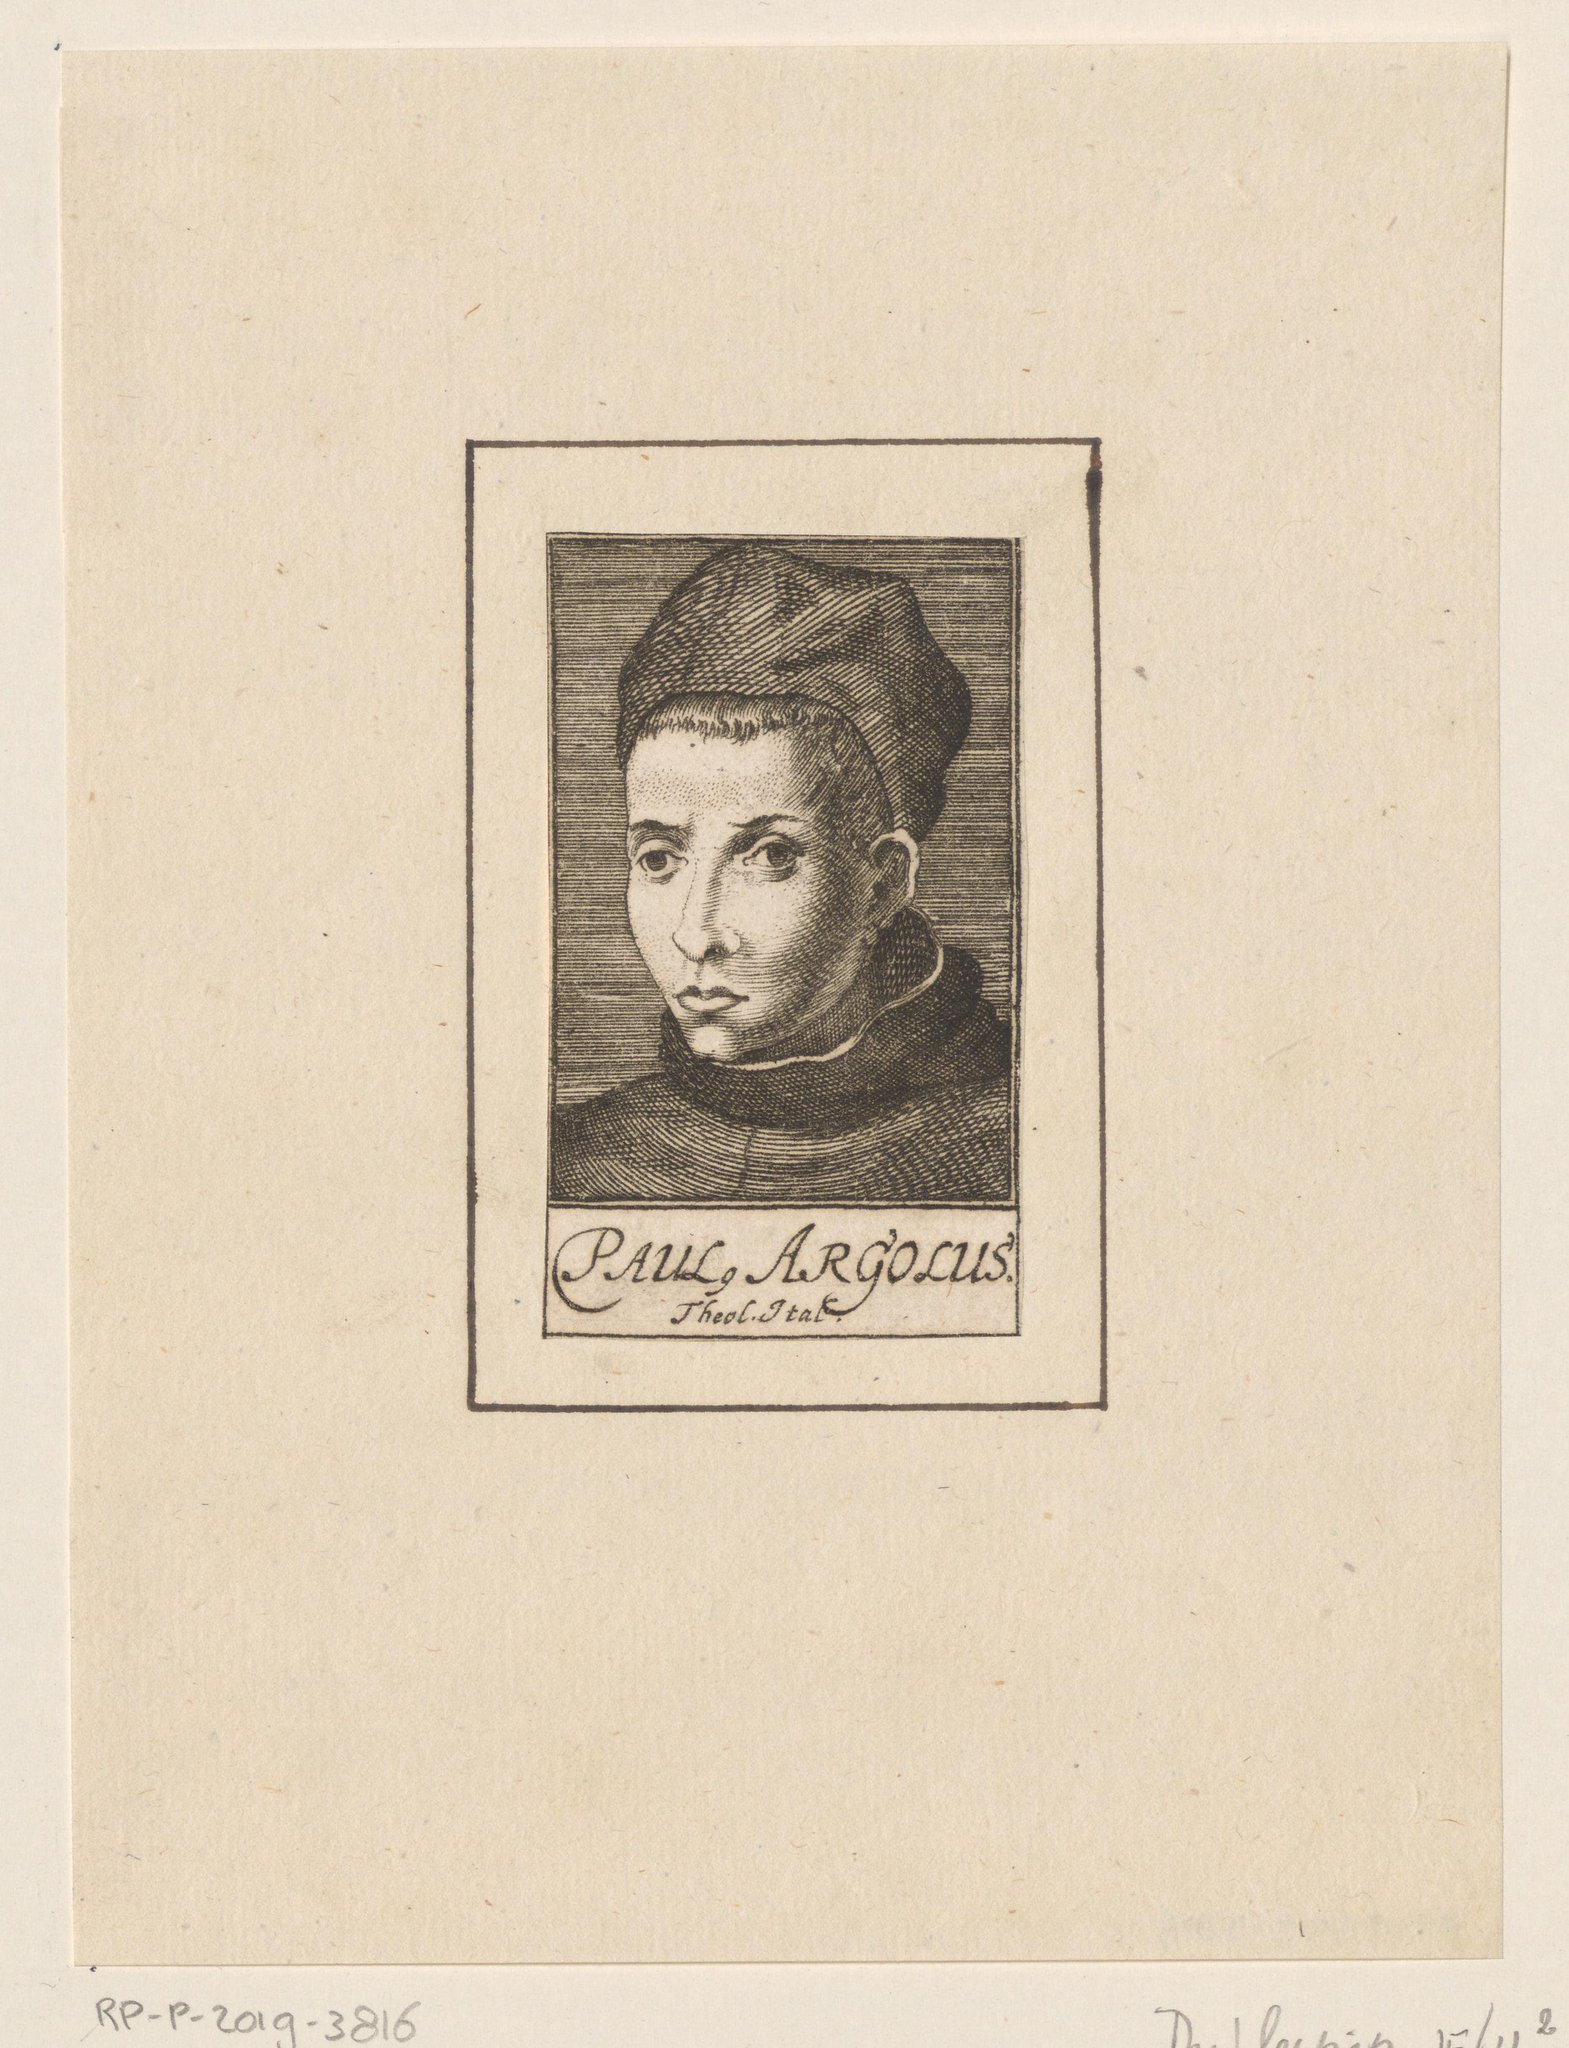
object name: print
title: Portret van Paolo Argoli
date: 1688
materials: paper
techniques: engraving, etching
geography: nuremberg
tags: historical persons, monk(s), friar(s)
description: Prent uit: Freher, Paul. Theatrum virorum eruditione clarorum. Neurenberg: Johann Hoffmann, 1688.